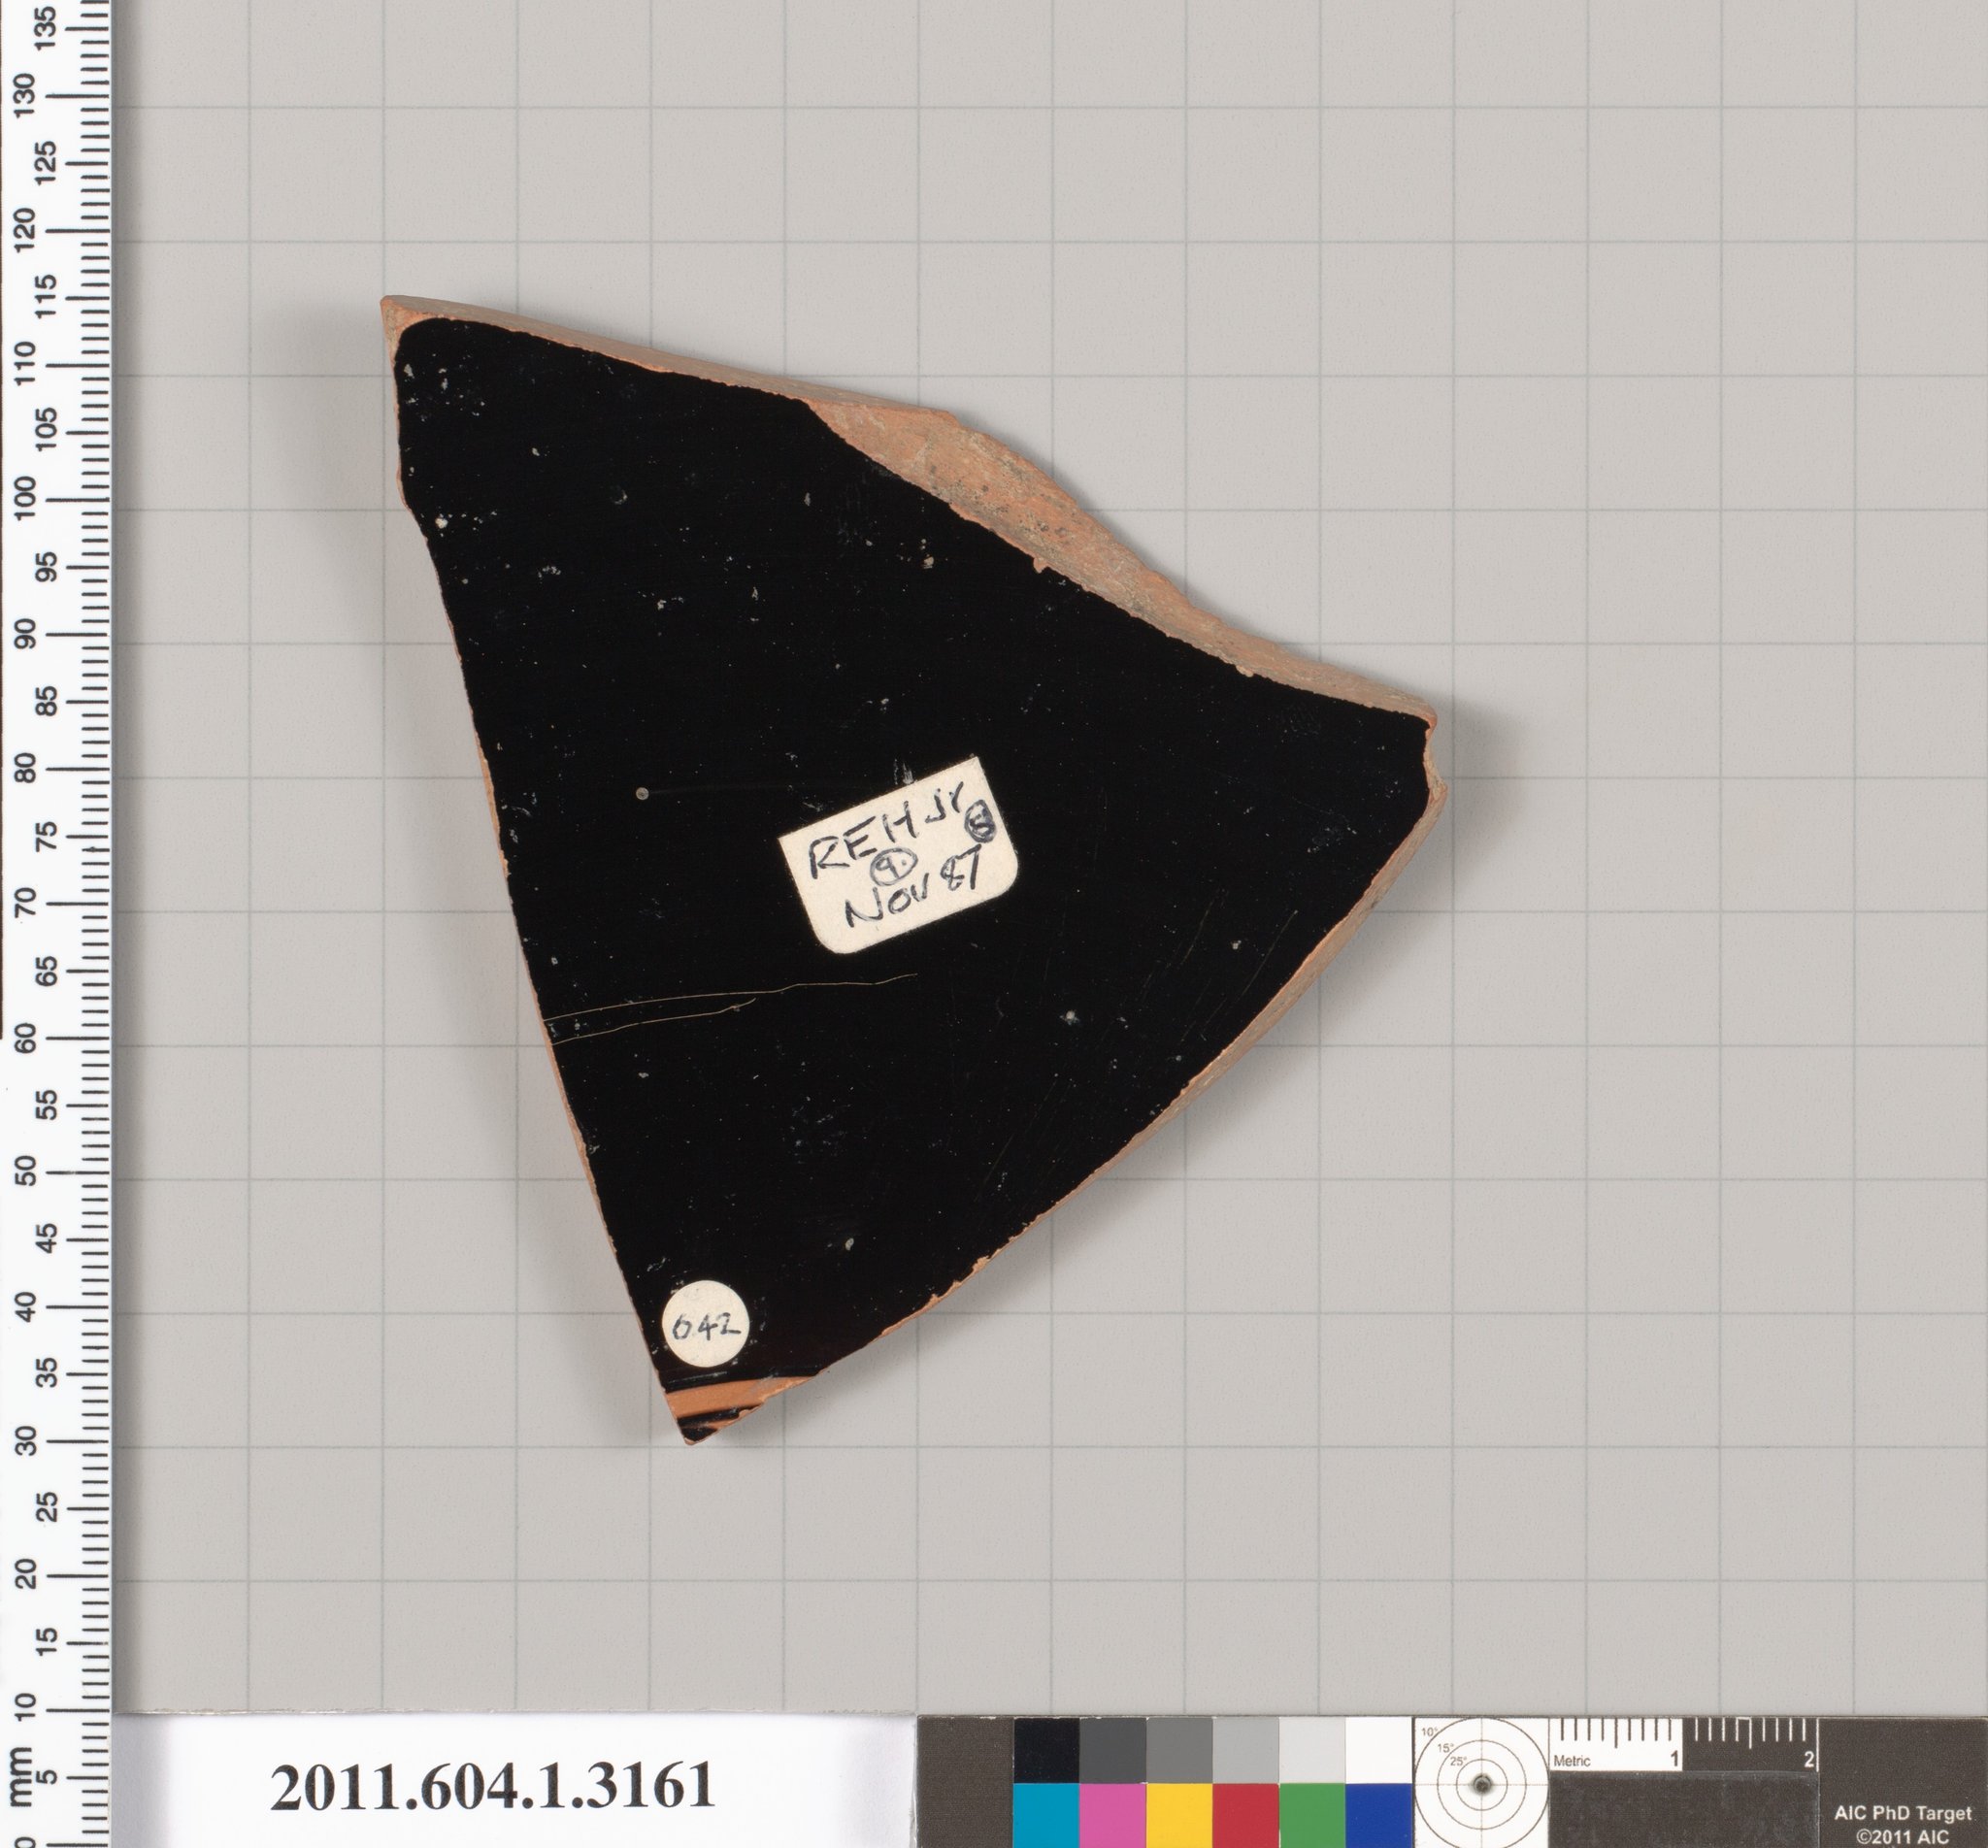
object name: kylix fragment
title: Terracotta fragment of a kylix (drinking cup)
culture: greek, attic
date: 520-500 BCE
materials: terracotta